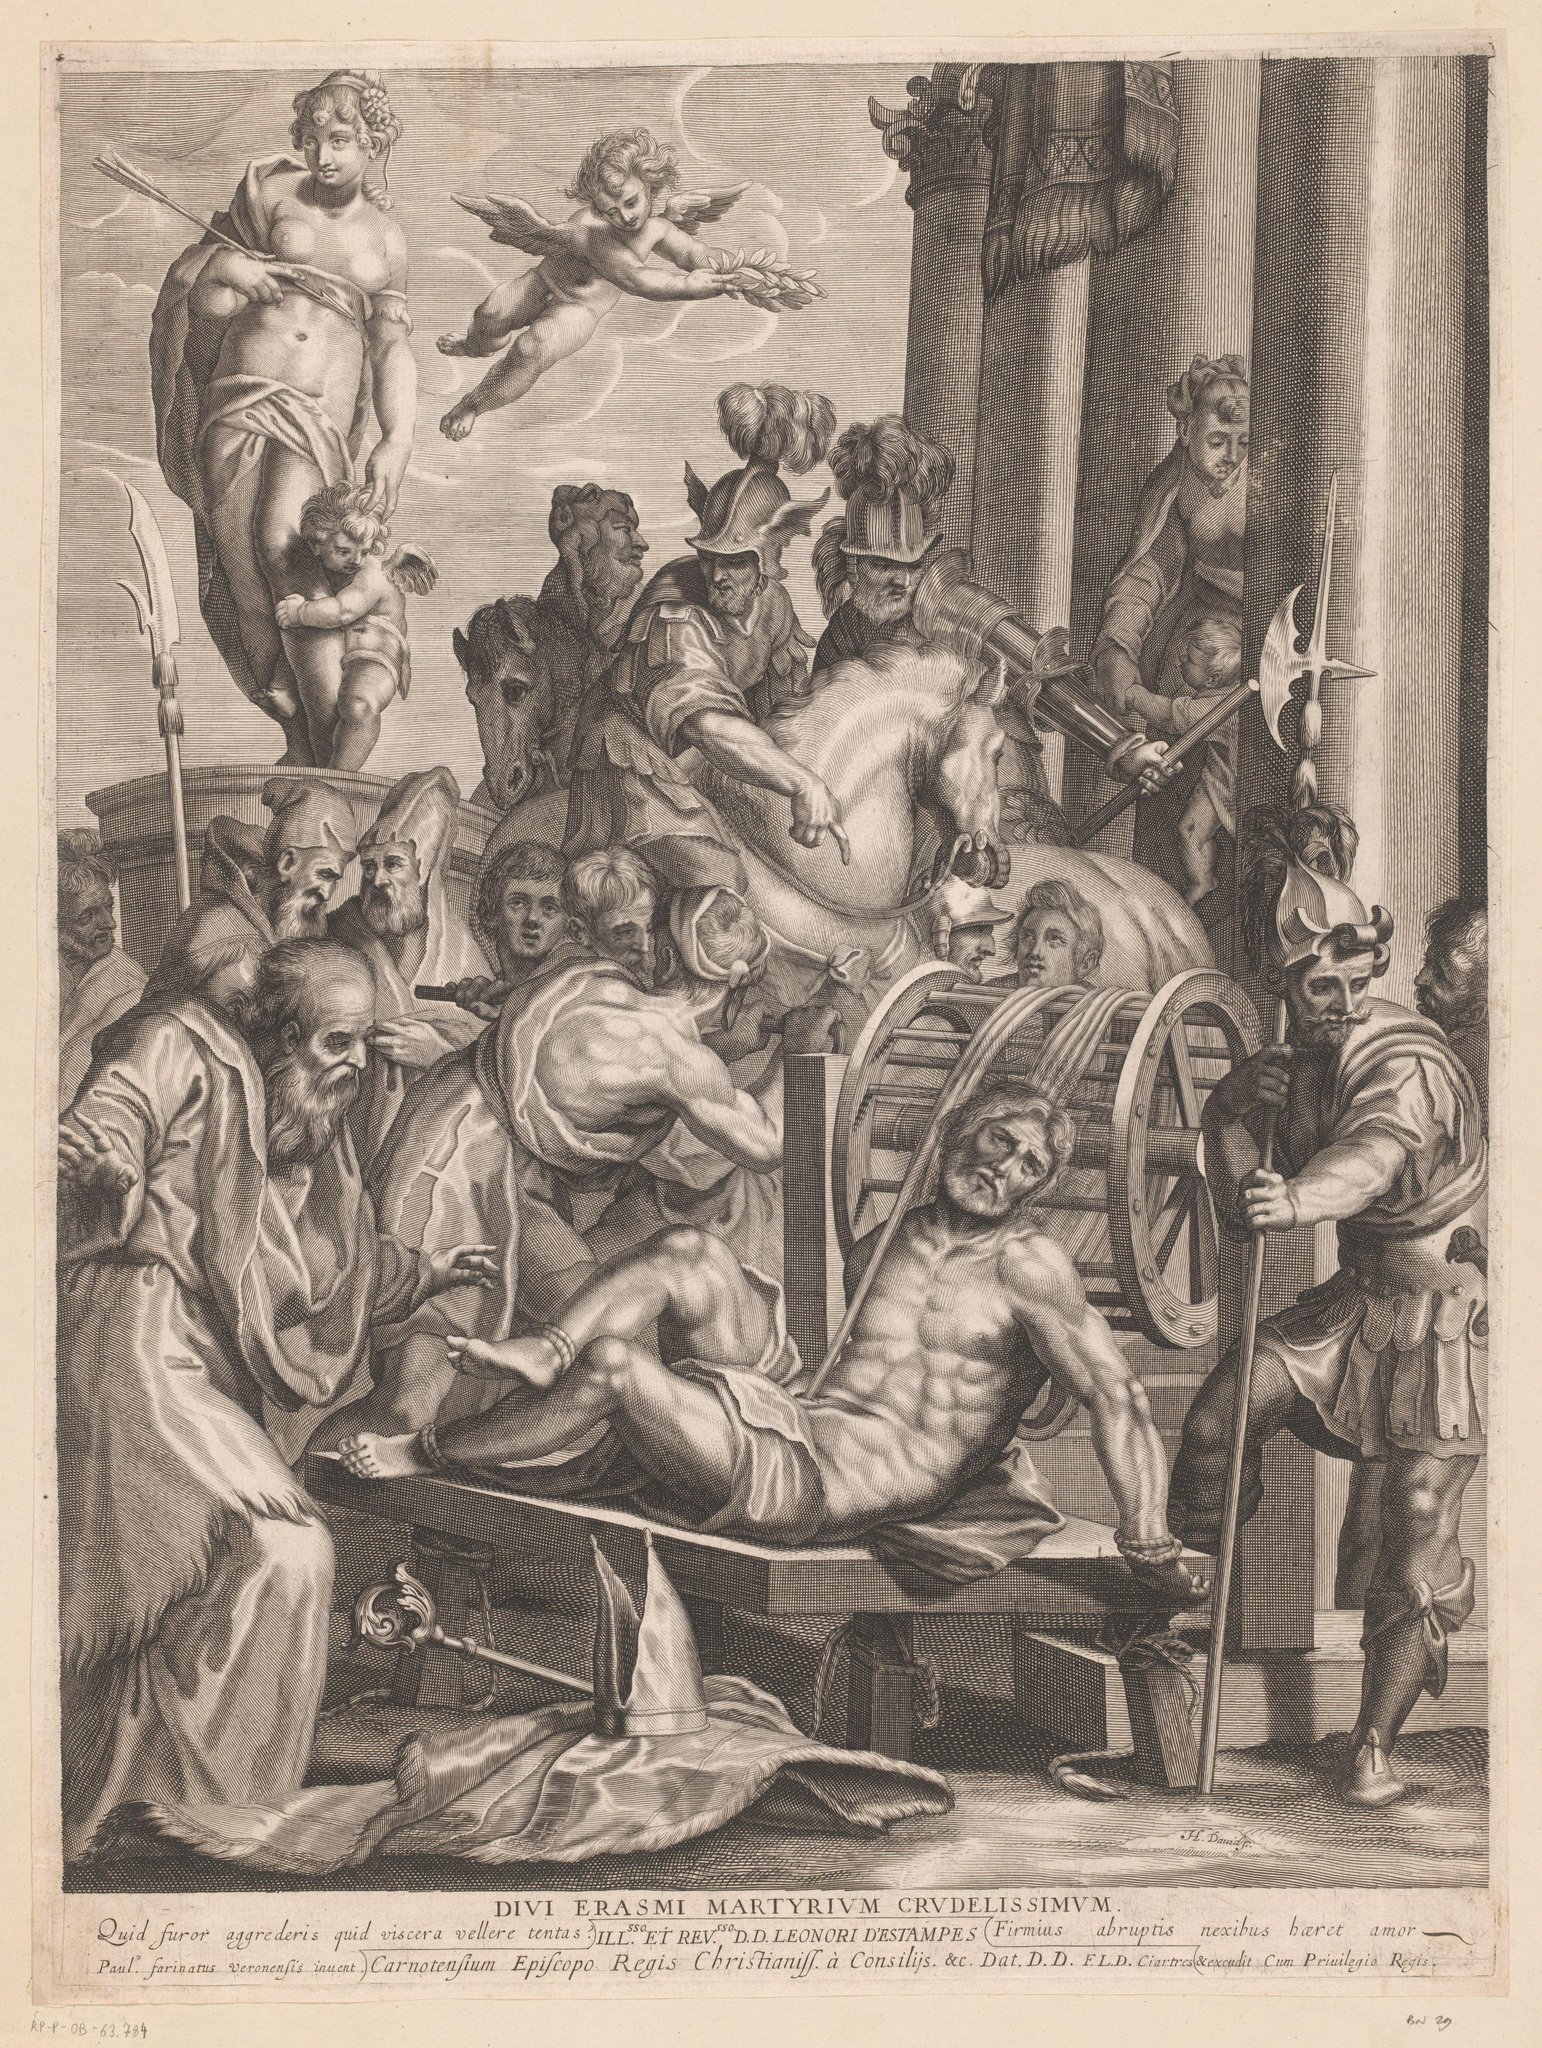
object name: print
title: Martelaarschap van H. Erasmus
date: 1615-1647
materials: paper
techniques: engraving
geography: paris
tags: st. erasmus lies naked on a block; his bowels are wound on to a windlass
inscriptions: collector's mark: Lugt 240